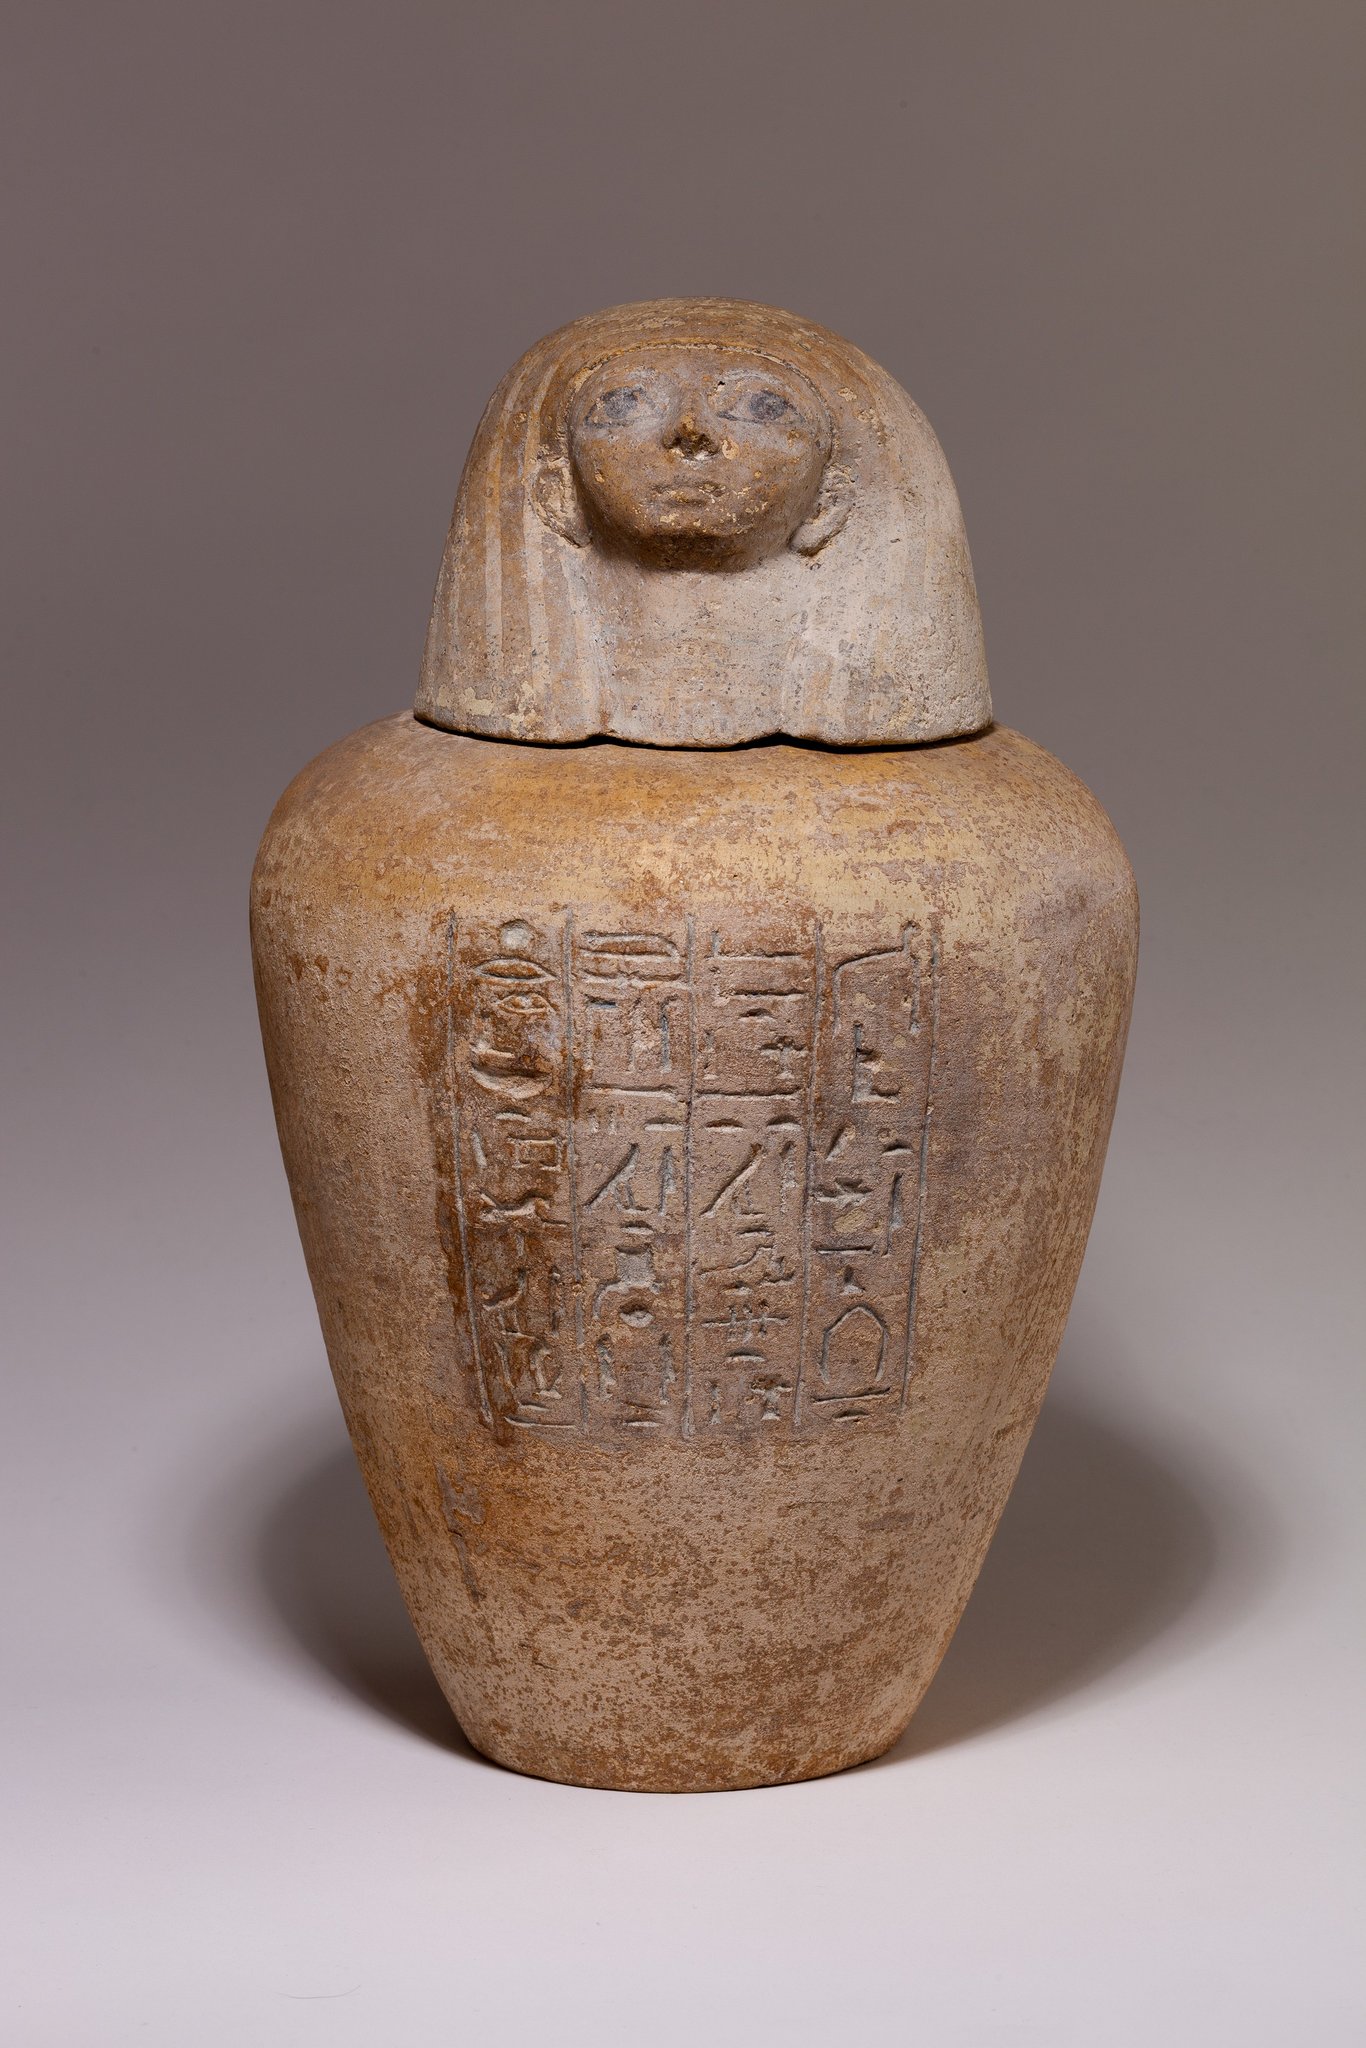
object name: canopic jar, ruiu, human head, hapy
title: Canopic Jar of Ruiu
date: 1504-1447 BCE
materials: paint, pottery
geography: egypt